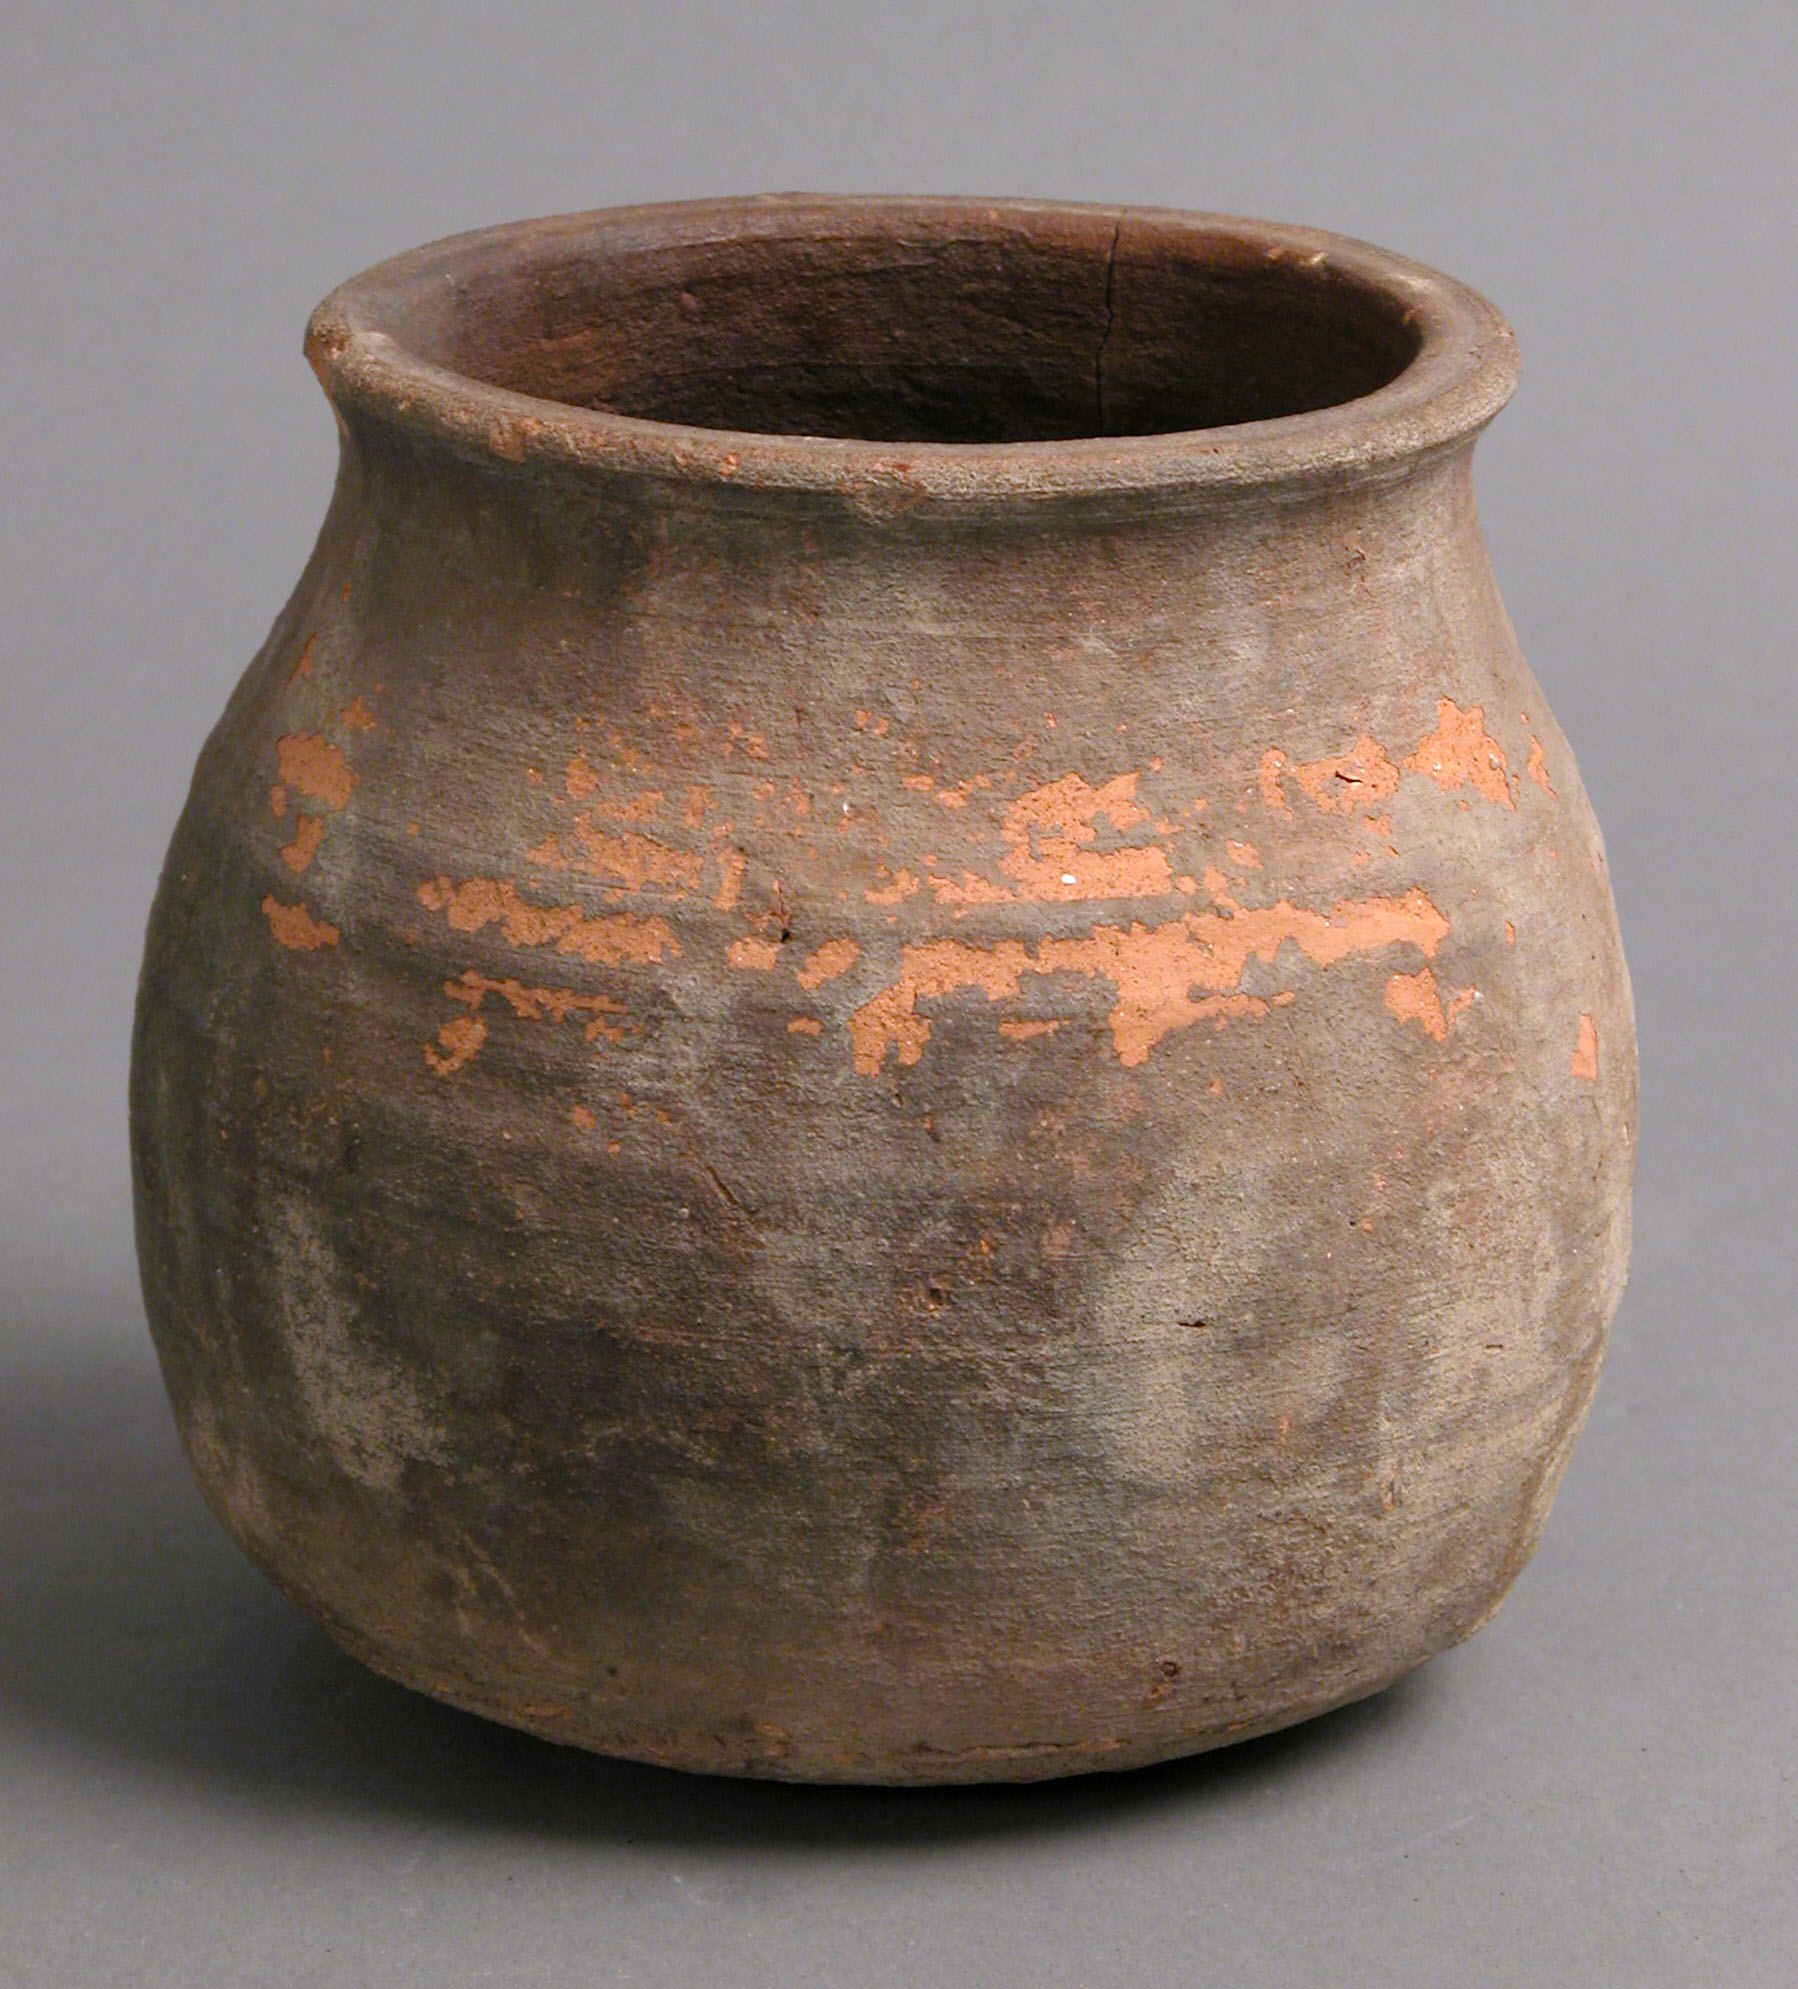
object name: pot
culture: coptic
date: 301-700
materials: earthenware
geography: egypt